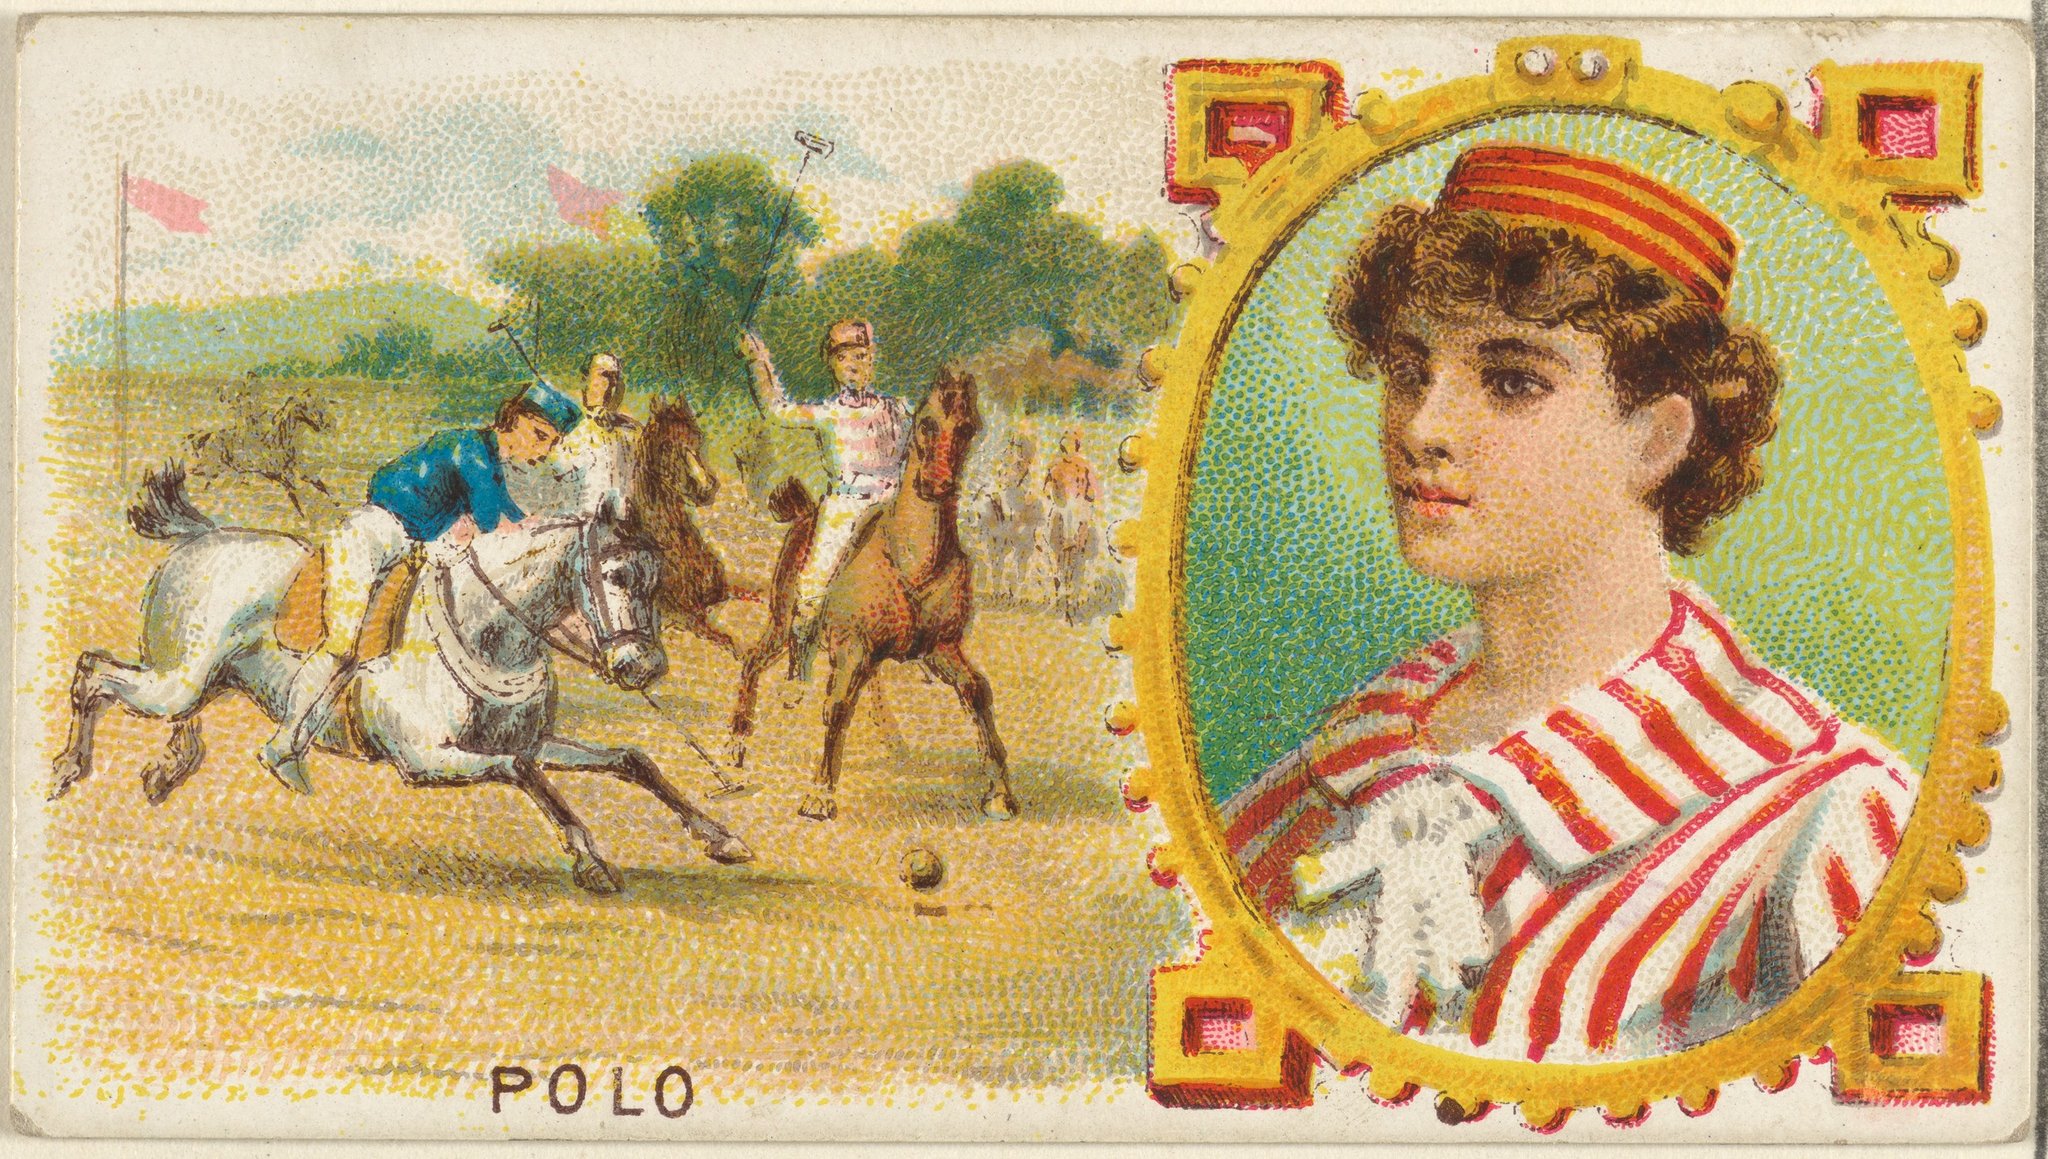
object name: print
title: Polo, from the Games and Sports series (N165) for Old Judge Cigarettes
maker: goodwin & company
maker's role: publisher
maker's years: 1850-1950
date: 1889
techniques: color lithograph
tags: women,sports,horses